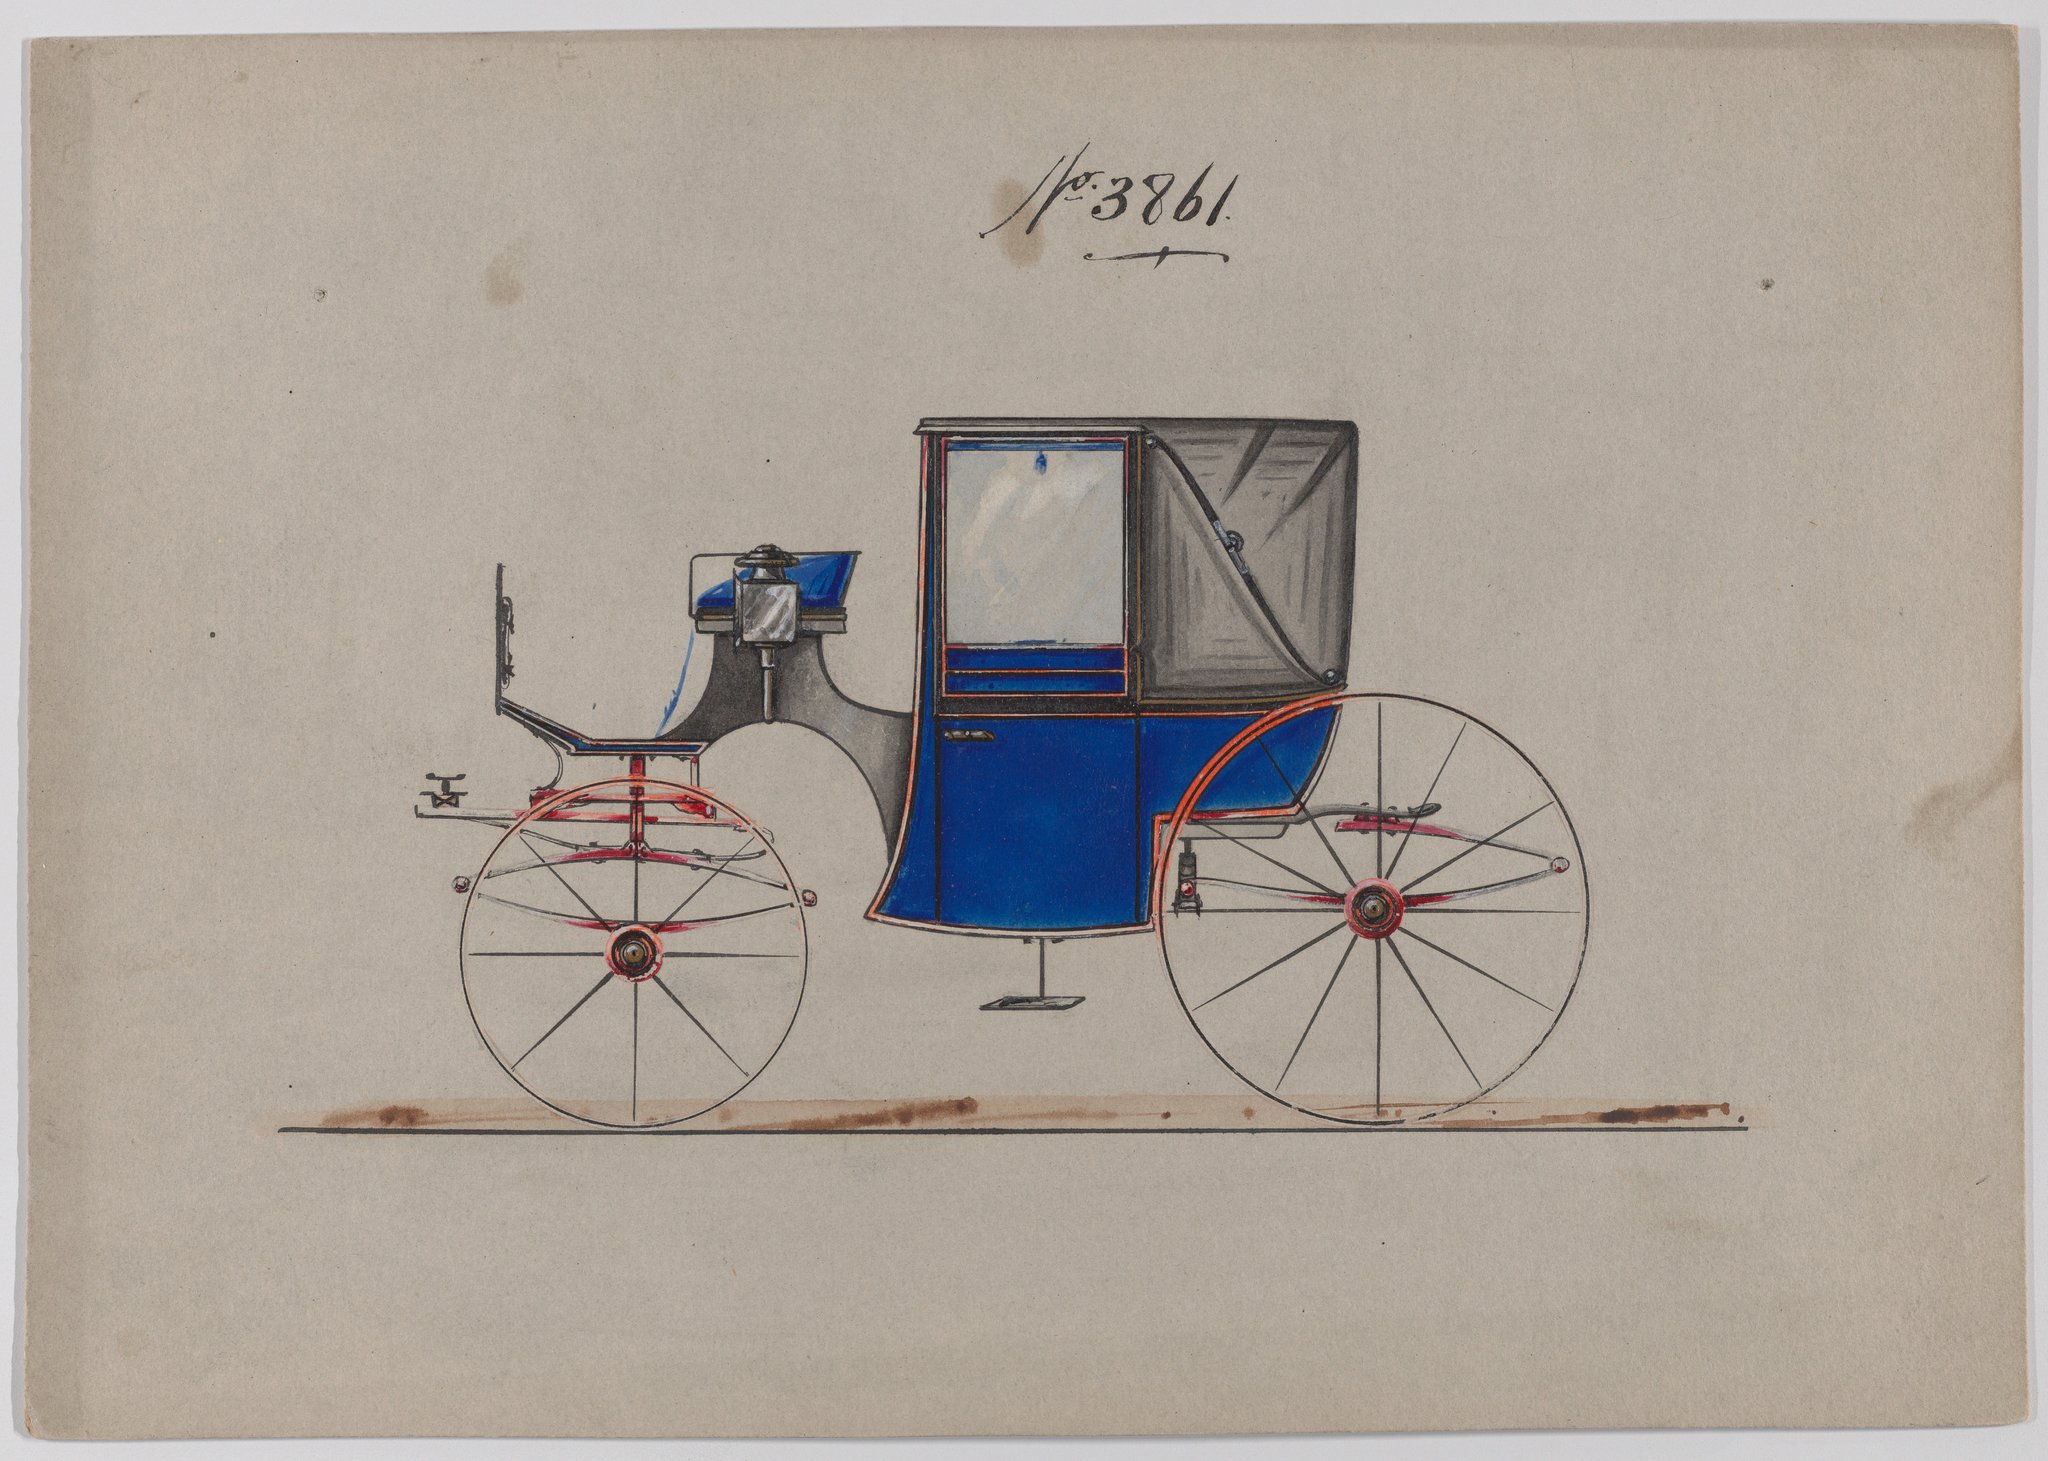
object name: drawing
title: Design for Landaulet, no. 3861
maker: brewster & co.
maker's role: manufacturer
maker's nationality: american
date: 1883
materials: gouache, gum arabic, ink, watercolor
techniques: pen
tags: carriages